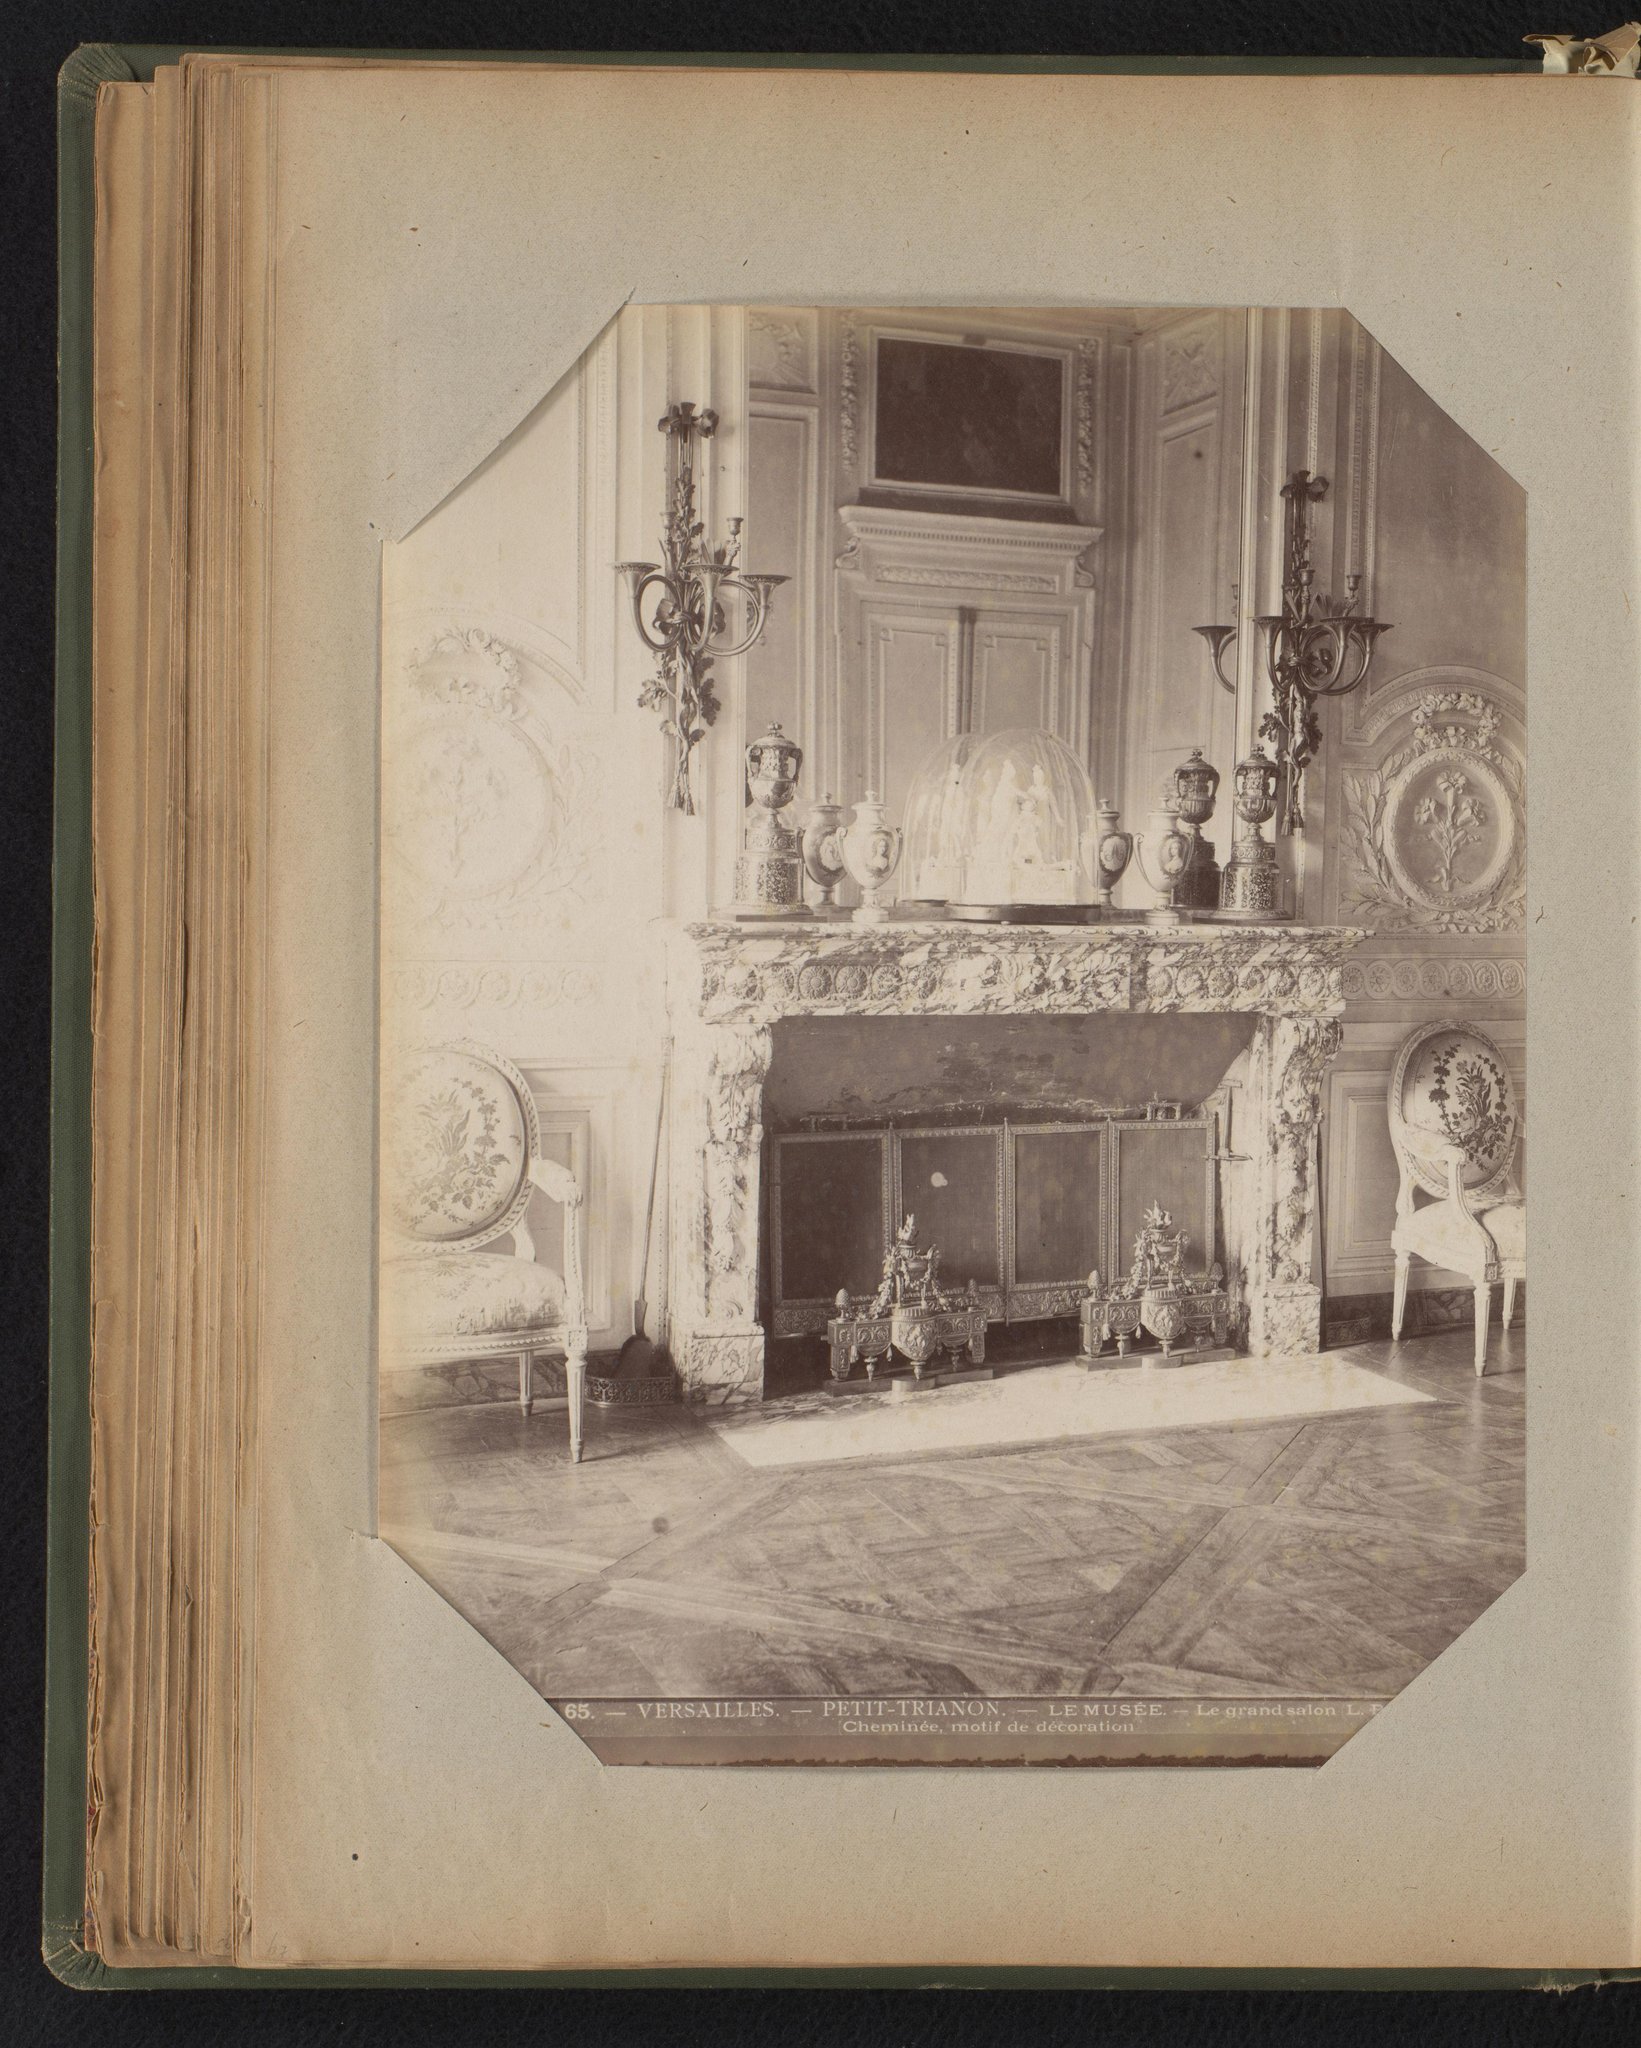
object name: photograph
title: 65. -Versailles - Petit Trianon - Le Musee - Le grand Salon )L.P. Phot) Cheminee, motif de decoration.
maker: Anonymous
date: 1860-1900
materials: paper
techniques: albumen print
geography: france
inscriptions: annotation: ‘65. -Versailles - Petit Trianon - Le Musee - Le grand Salon )L.P. Phot) Cheminee, motif de decoration.’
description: De schouw is voorzien van een aantal uitgehouwen bloemmotieven. Op de schouw staan kbronzen kandelaars, porceleinen vazen en een marmeren mantelstuk onder een stolp.